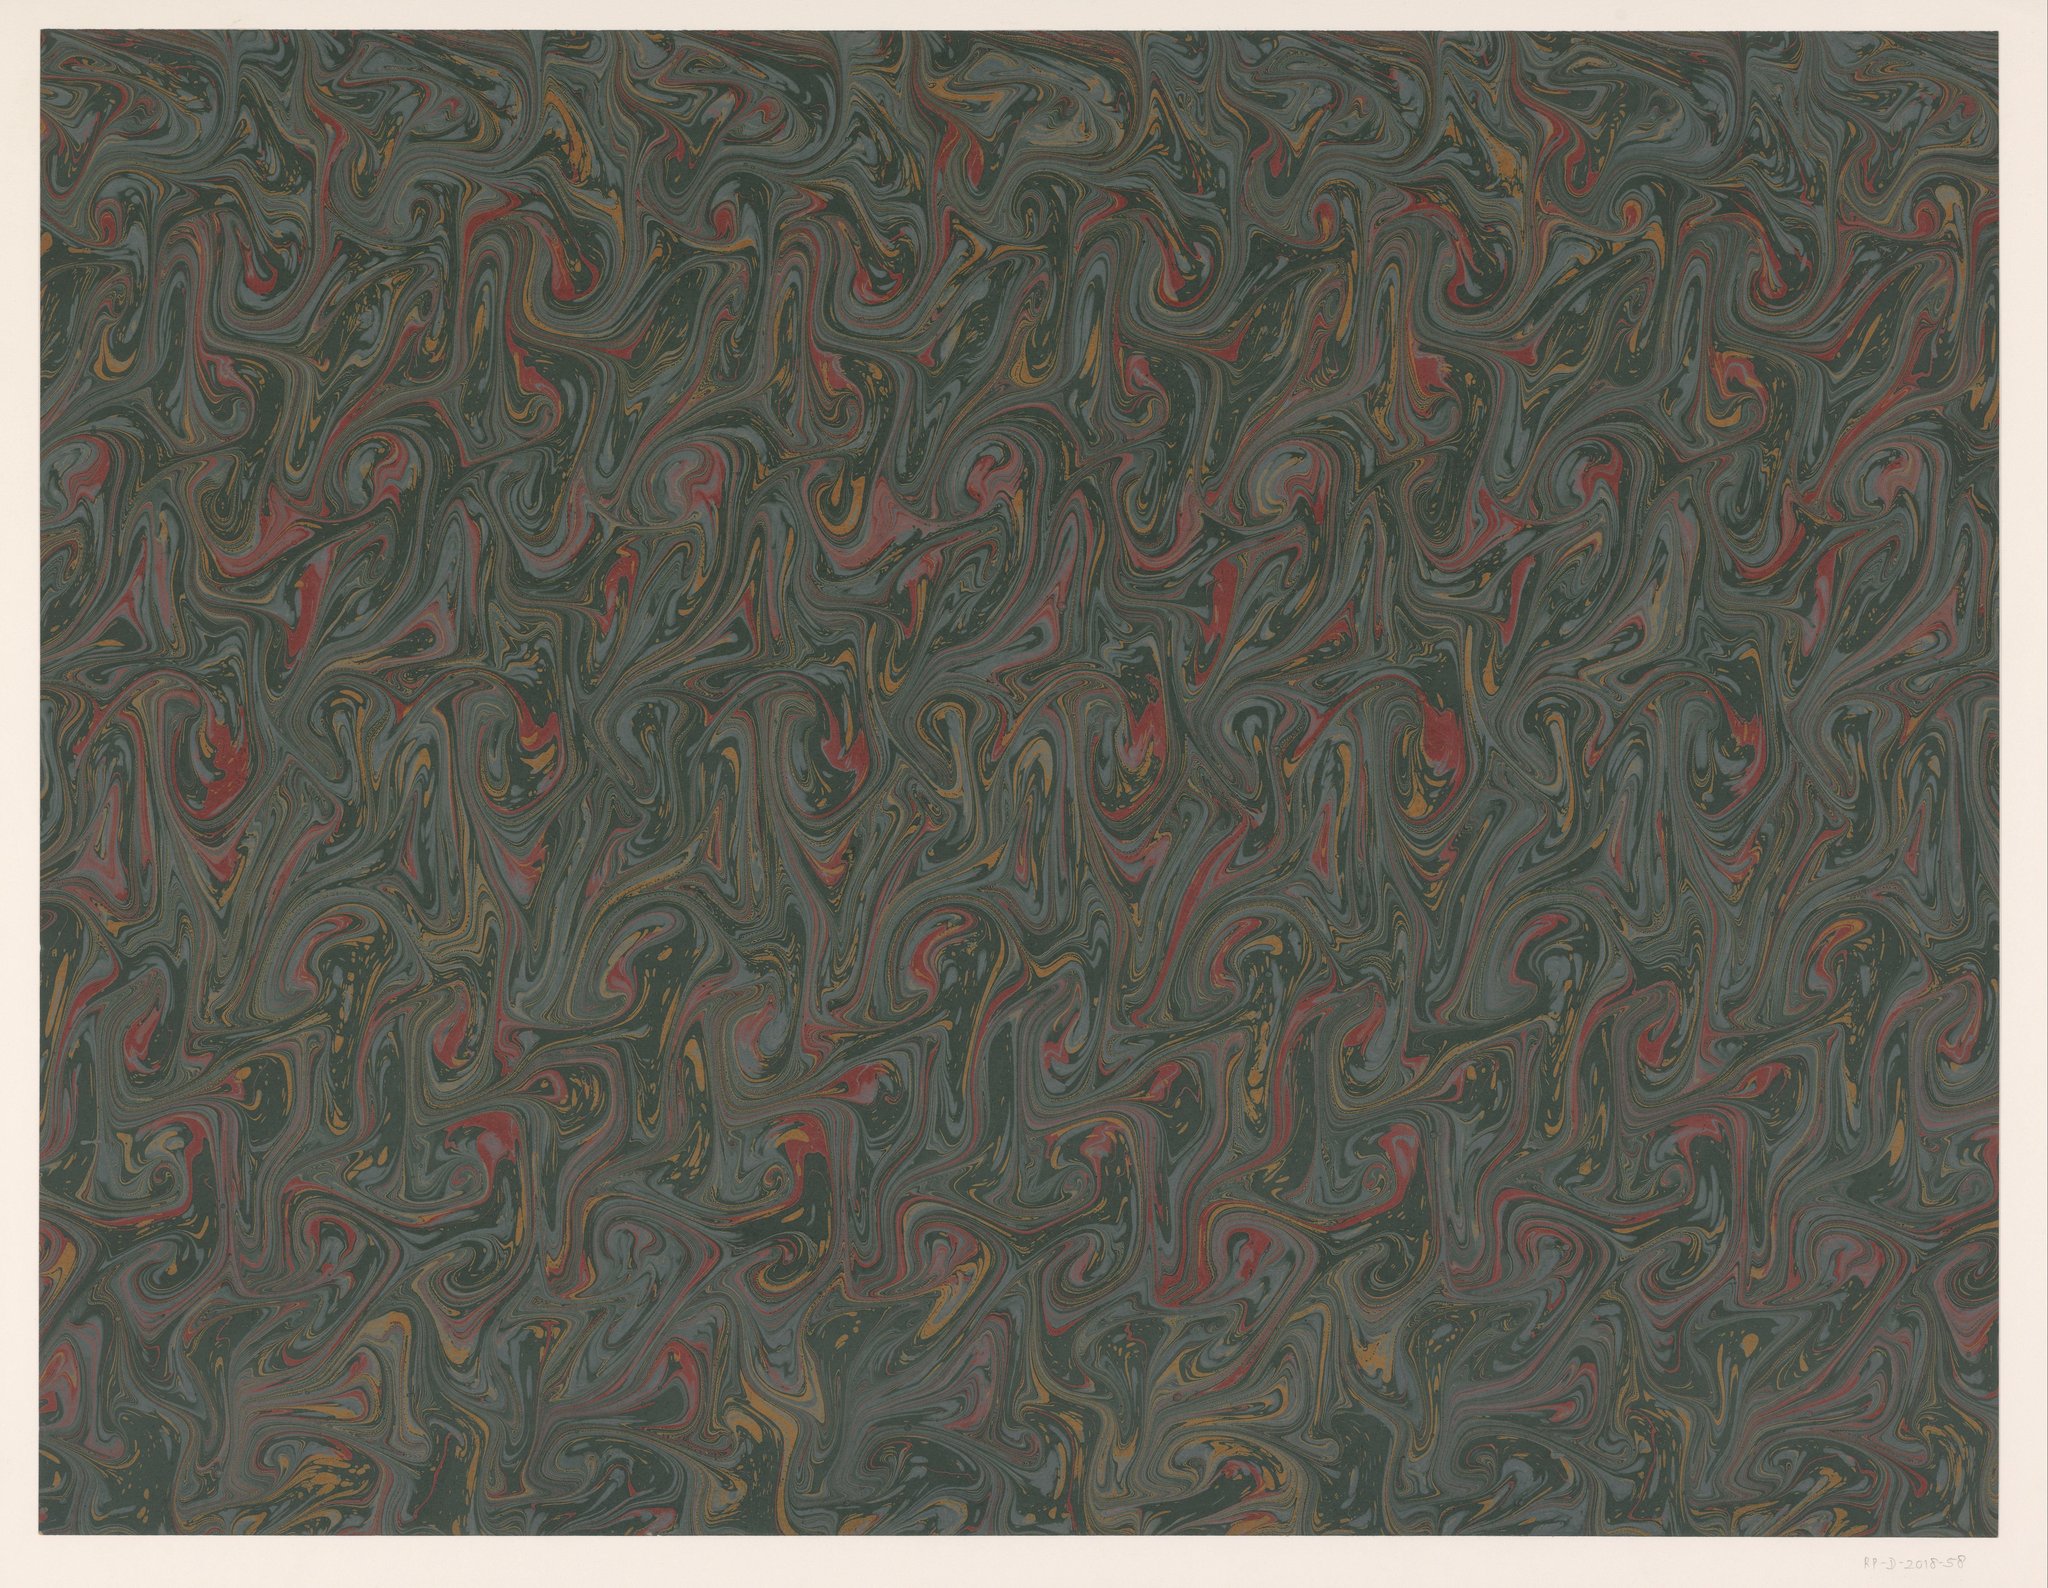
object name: marbled paper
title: Fantasiemarmer in groen, rood, geel en blauw op bruin papier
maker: Anonymous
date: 1900-2000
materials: paint, paper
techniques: marbled paper